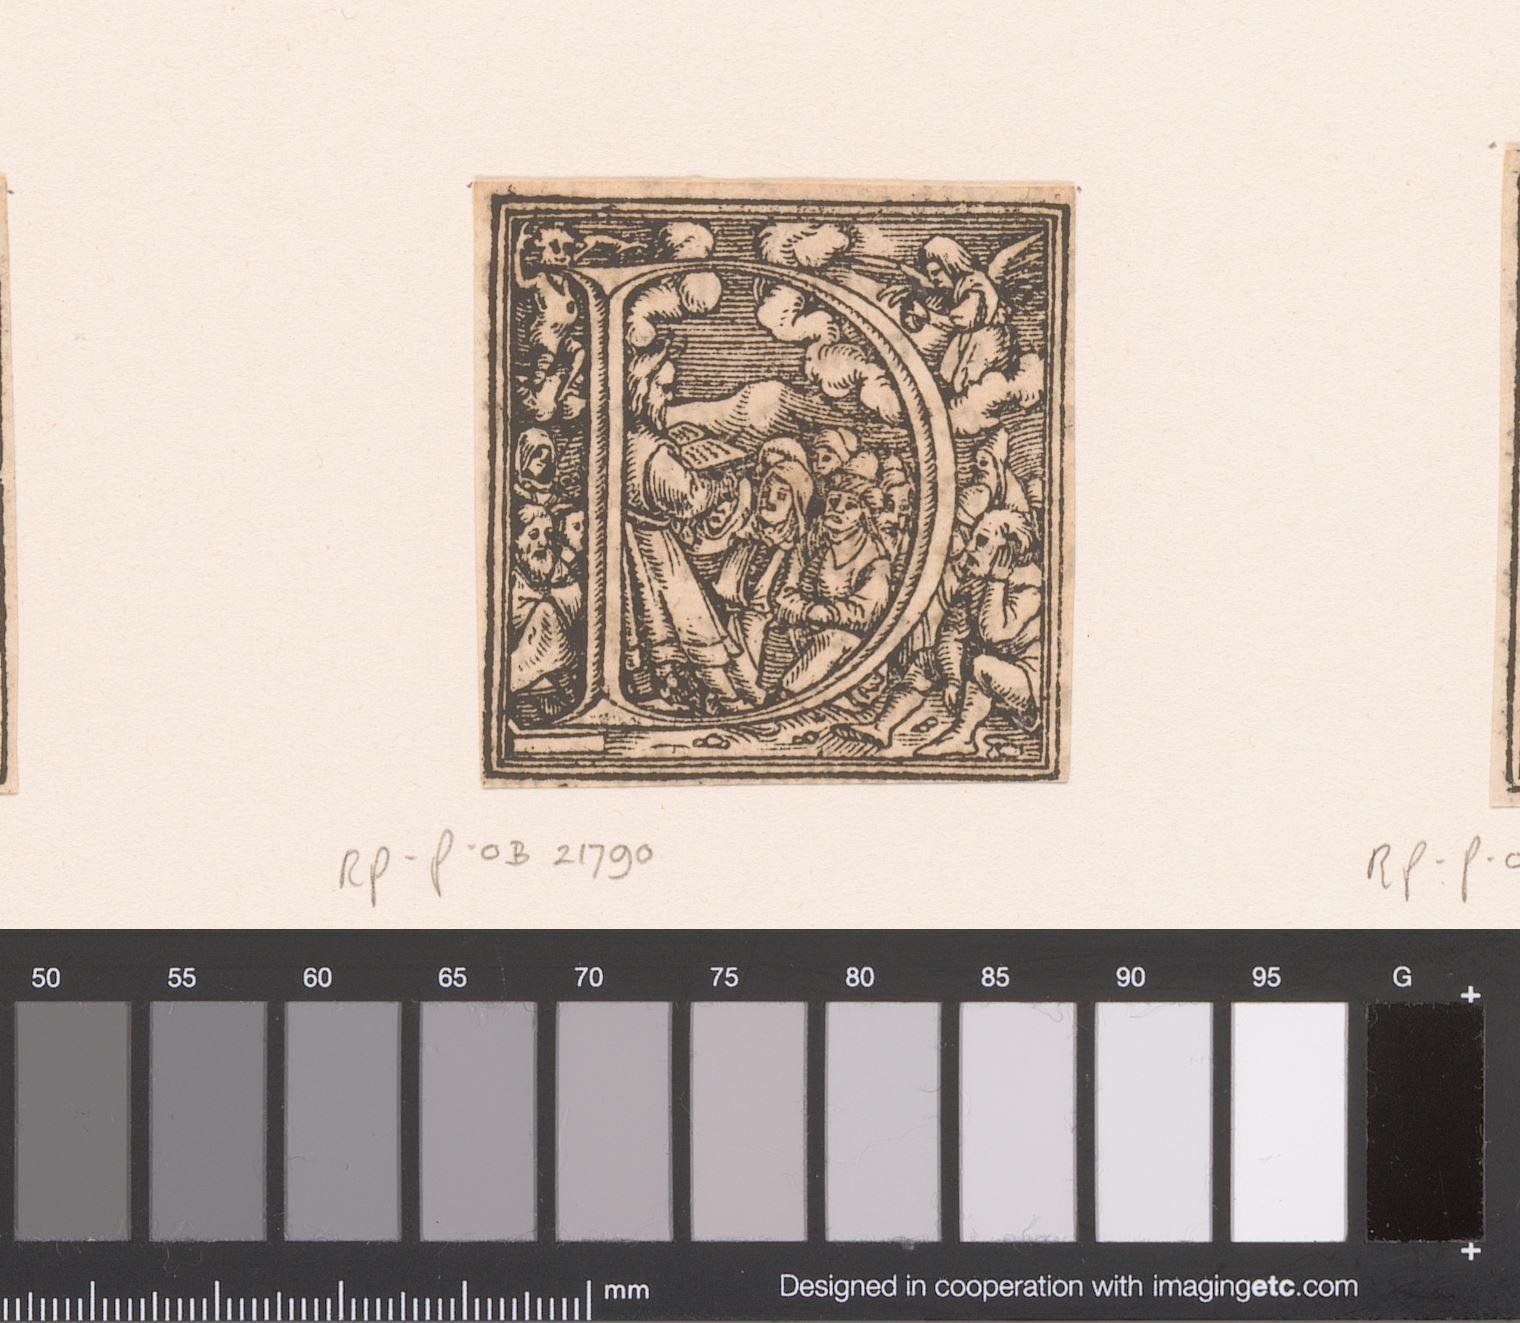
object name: print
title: Versierde initialen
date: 1556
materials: paper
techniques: letterpress printing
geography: zurich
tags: initial, moses teaching (in general)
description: Prent afkomstig uit: Bibel, die gantze, das ist alle Bücher alts und news Testaments (...). Zürich: Johann Froschauer, 1556.